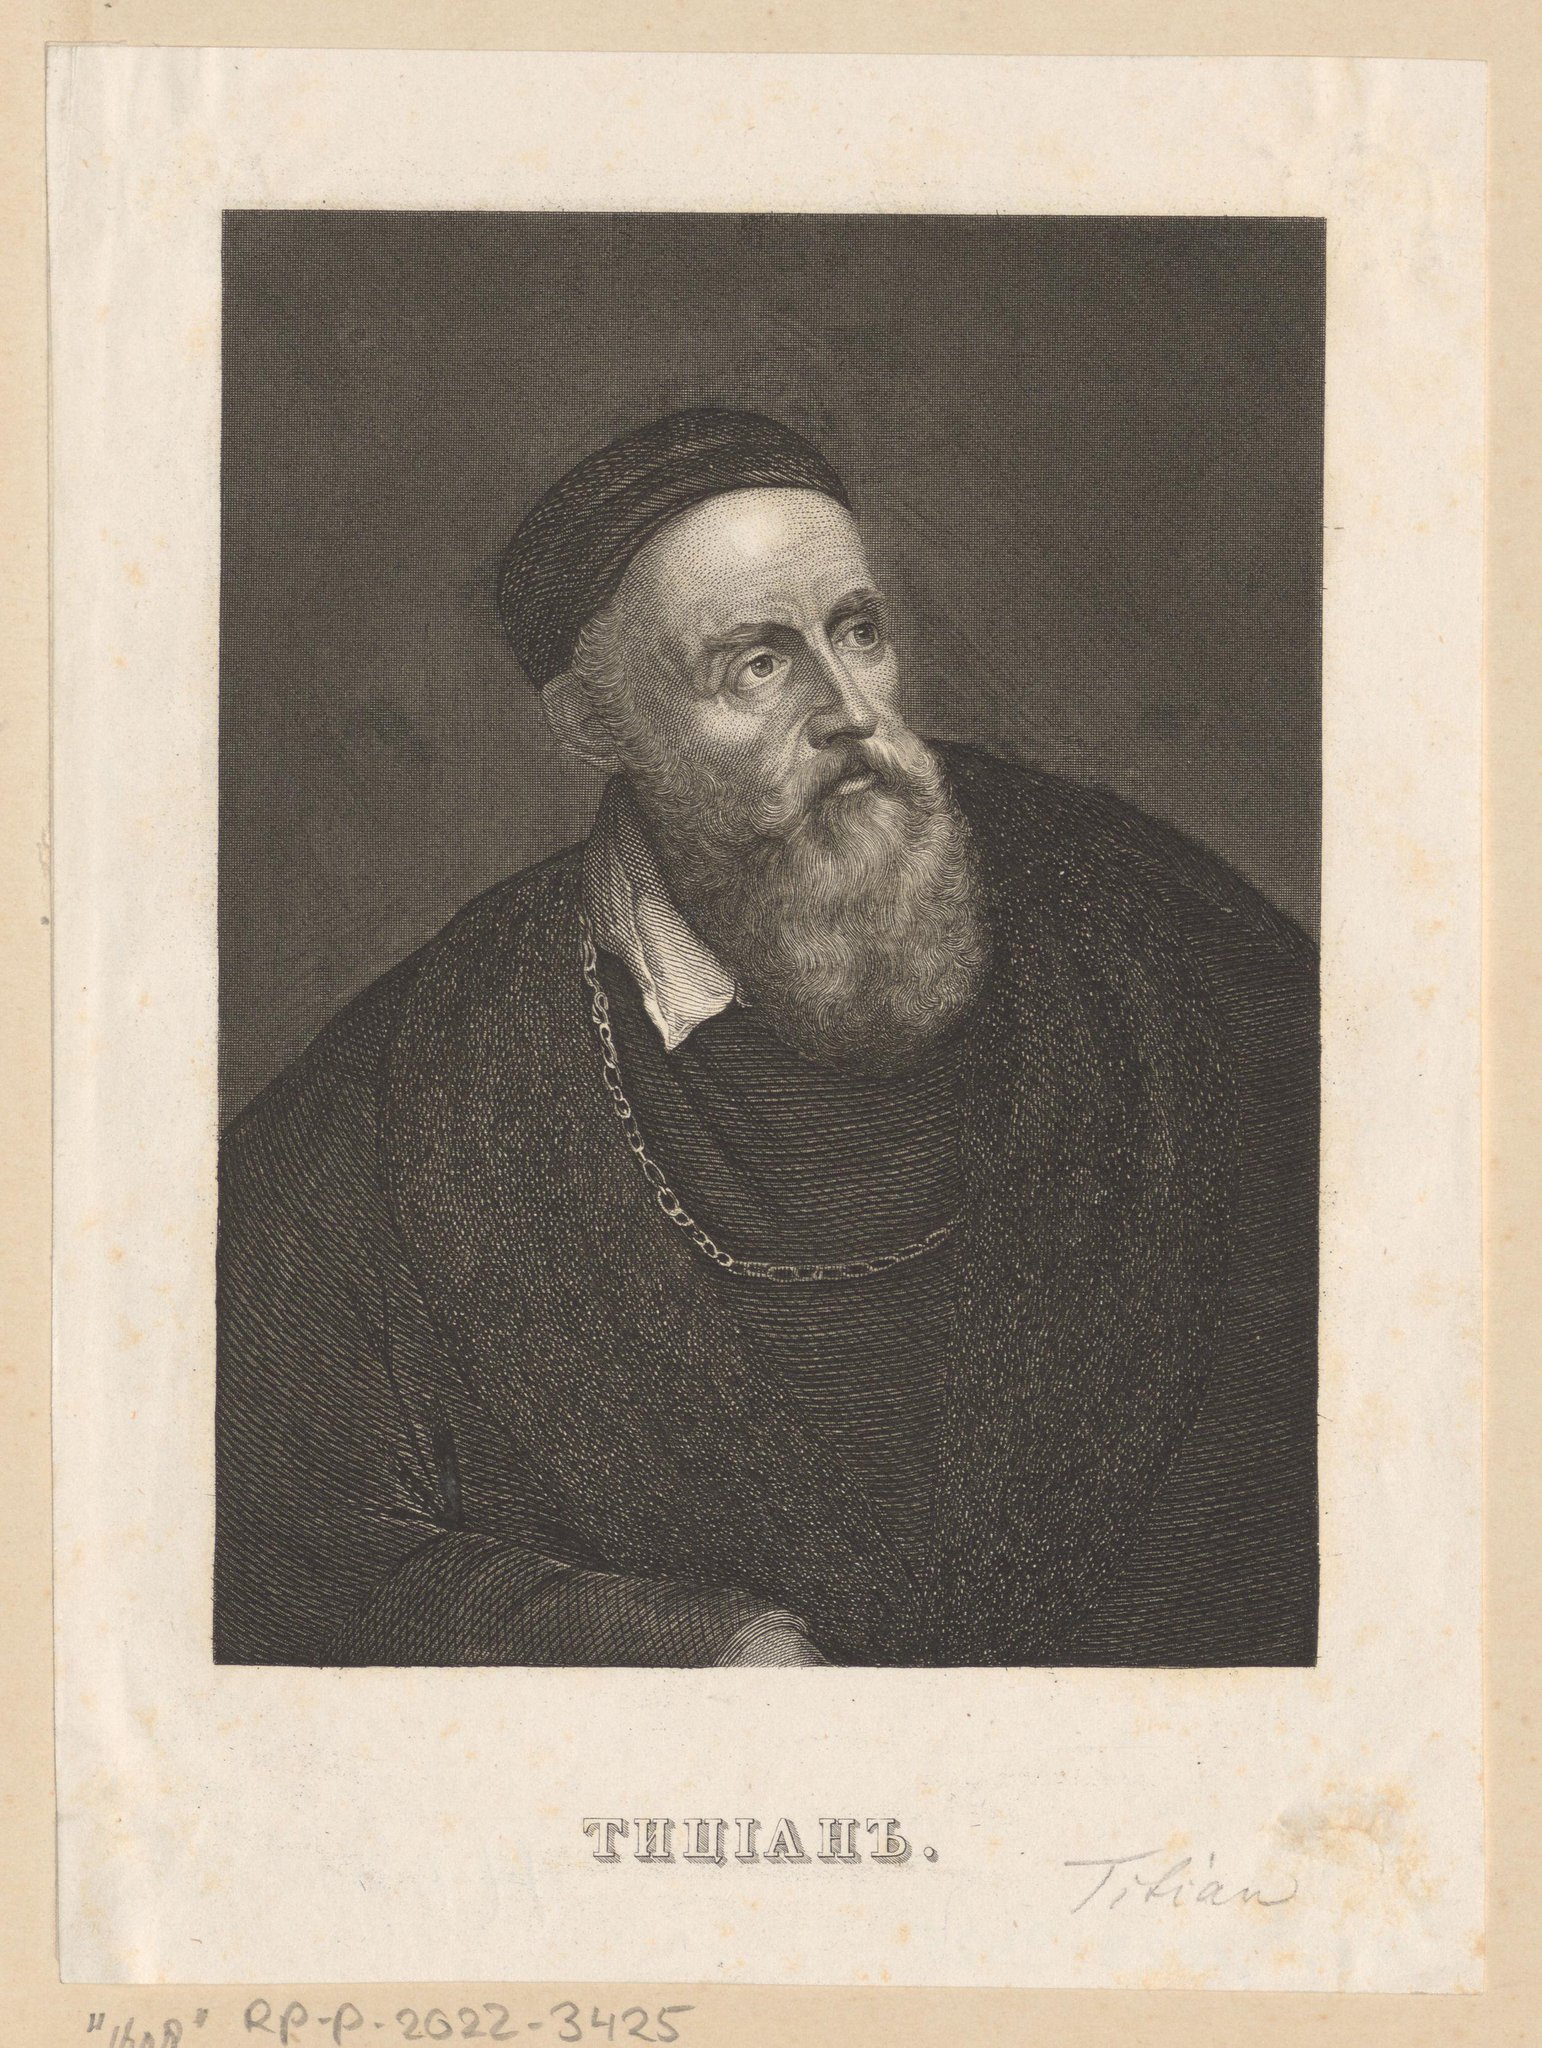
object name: print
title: Portret van Titiaan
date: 1750-1849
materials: paper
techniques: engraving, etching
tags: venice, painter, draughtsman, titiaan, historical persons, portrait, self-portrait of artist